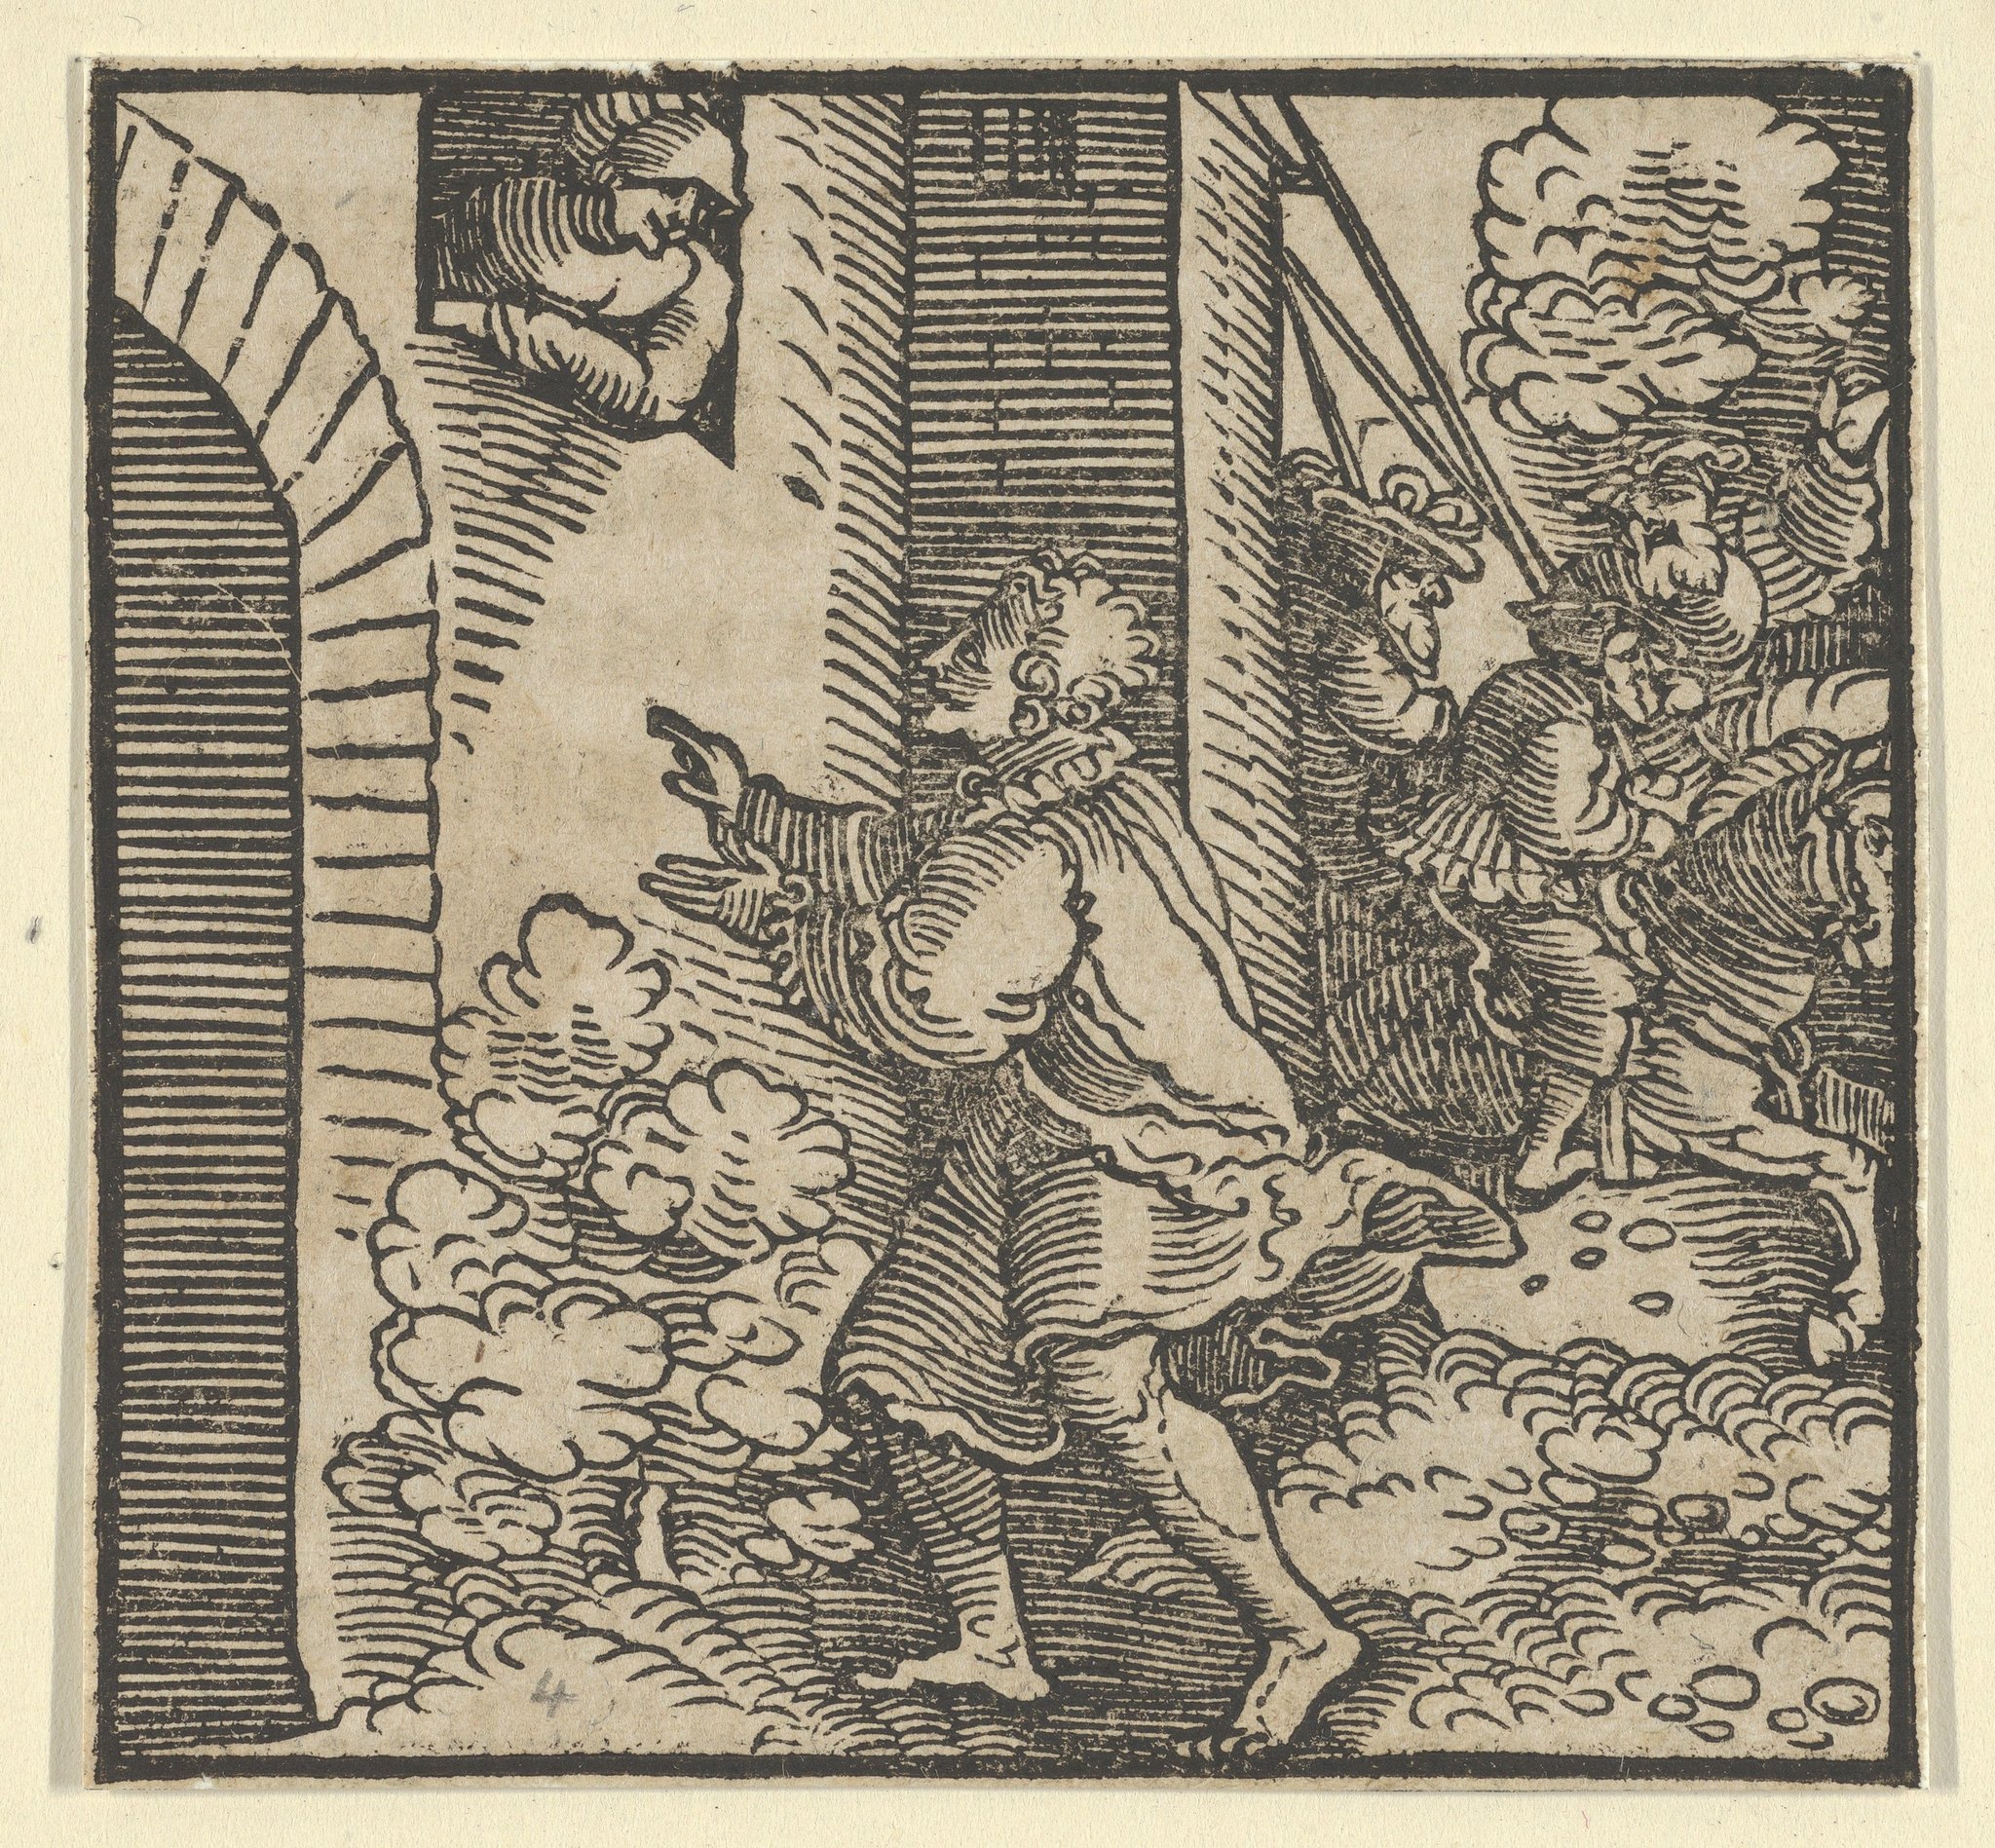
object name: print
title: Rinaldo Robbed, Standing in front of the Widow's House, from The Decameron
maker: hans schäufelein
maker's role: artist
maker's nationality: german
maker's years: 1480-1540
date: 1534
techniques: woodcut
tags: men,women